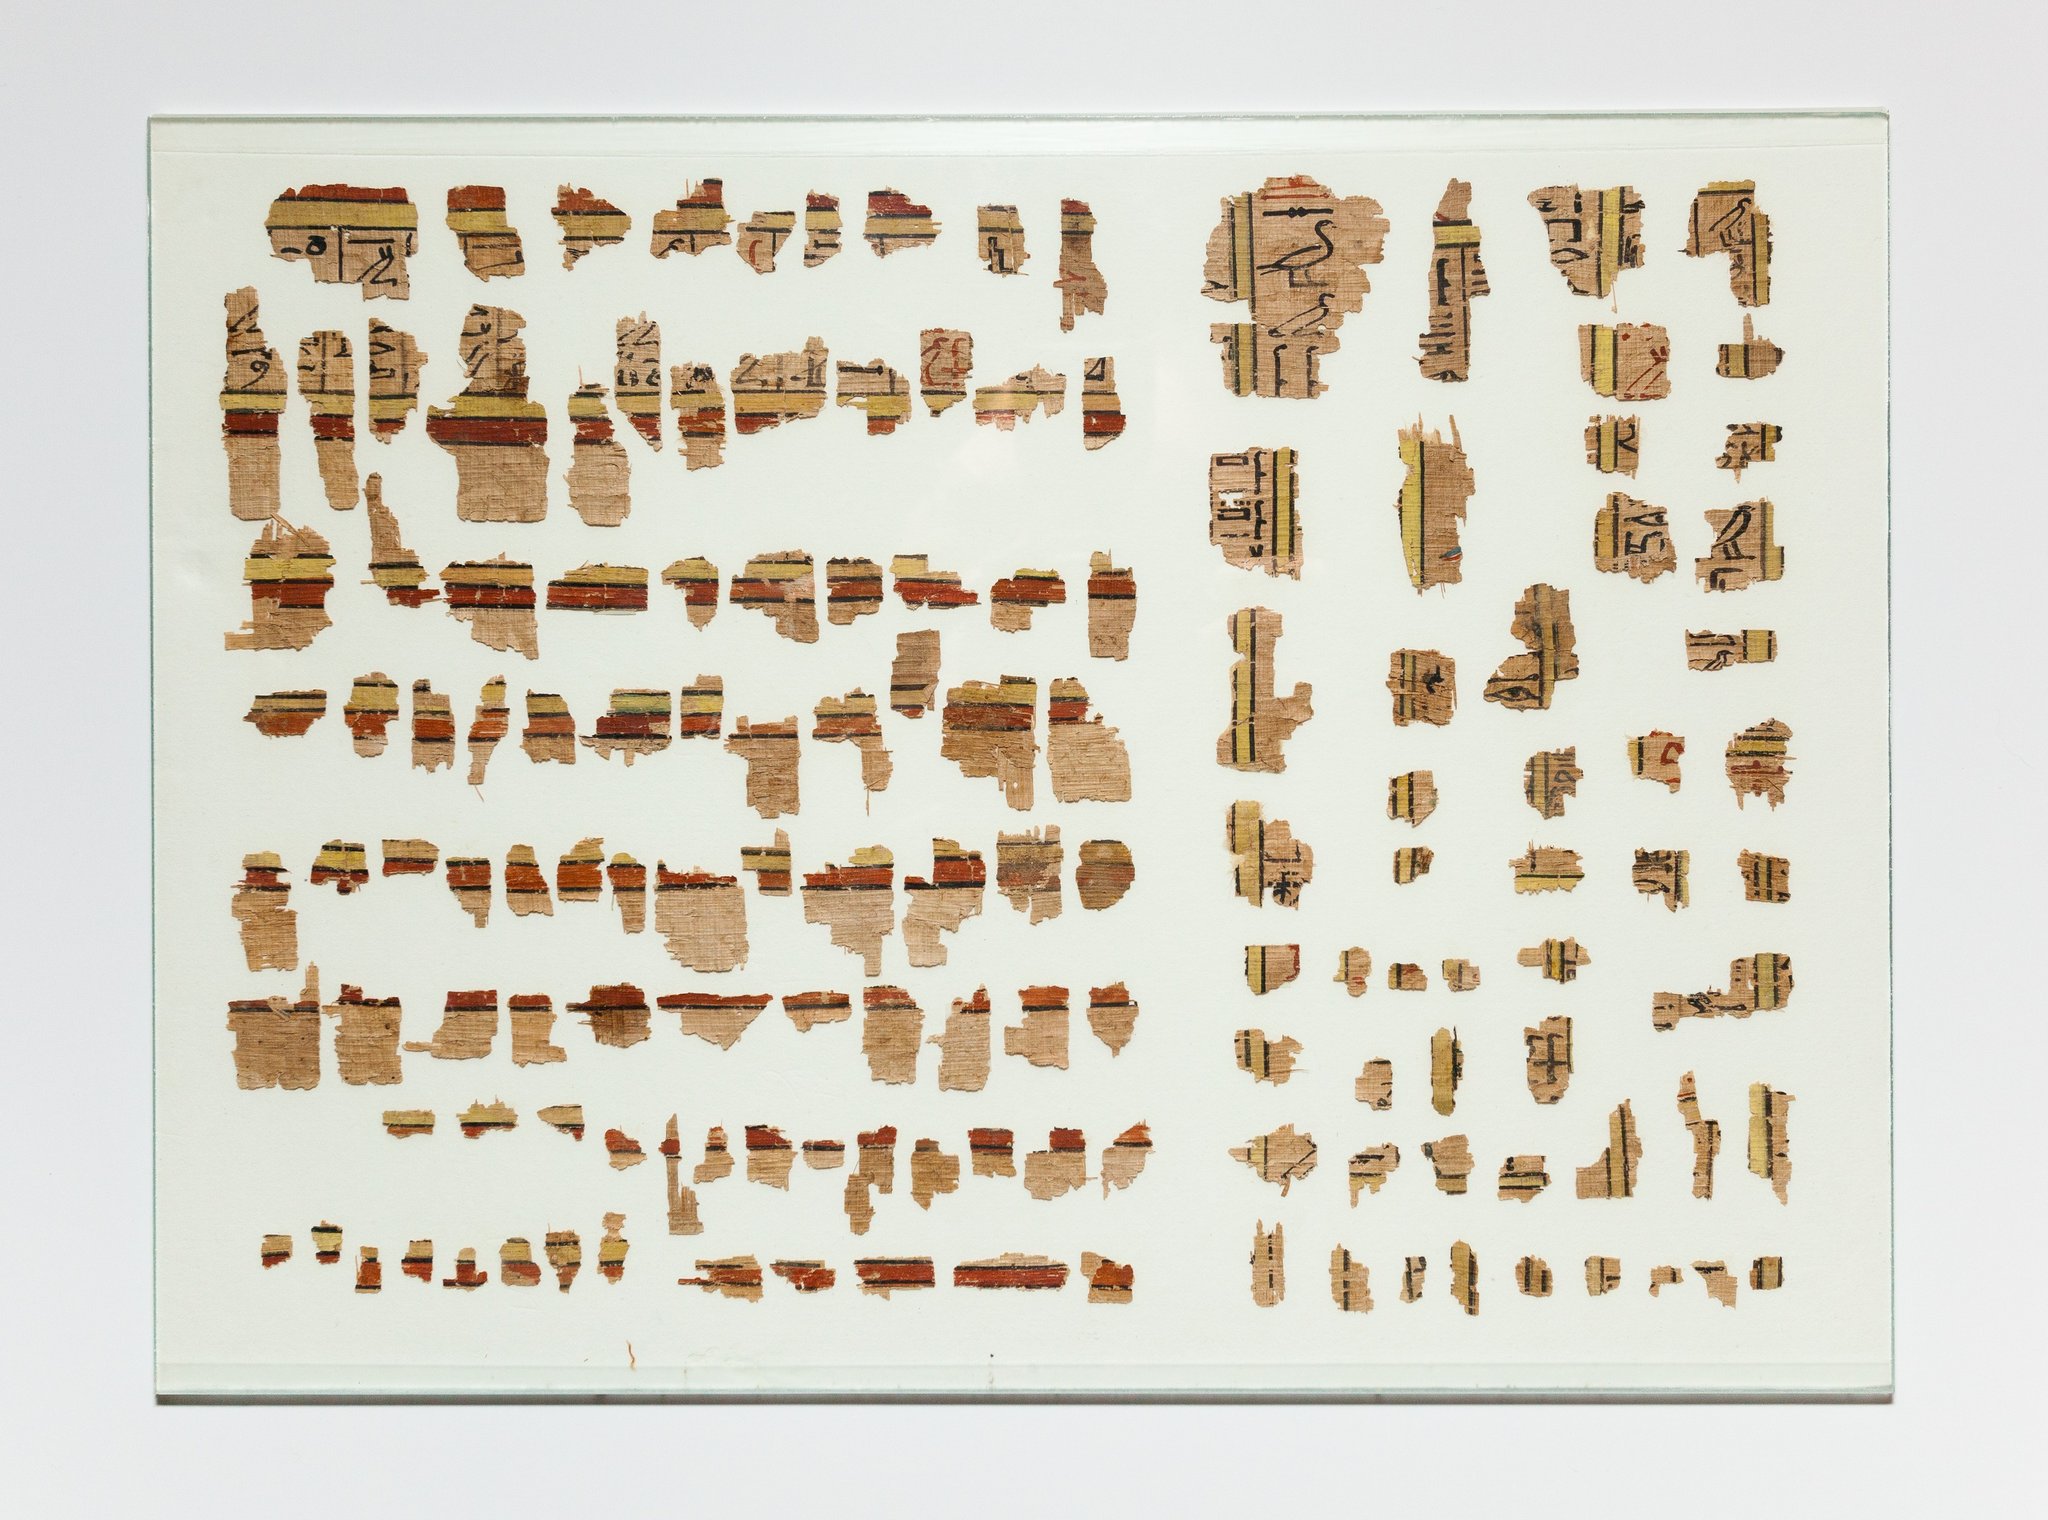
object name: papyrus, funerary, book of the dead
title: Fragments from a Book of the Dead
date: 1390-1353 BCE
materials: ink, papyrus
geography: egypt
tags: hieroglyphs